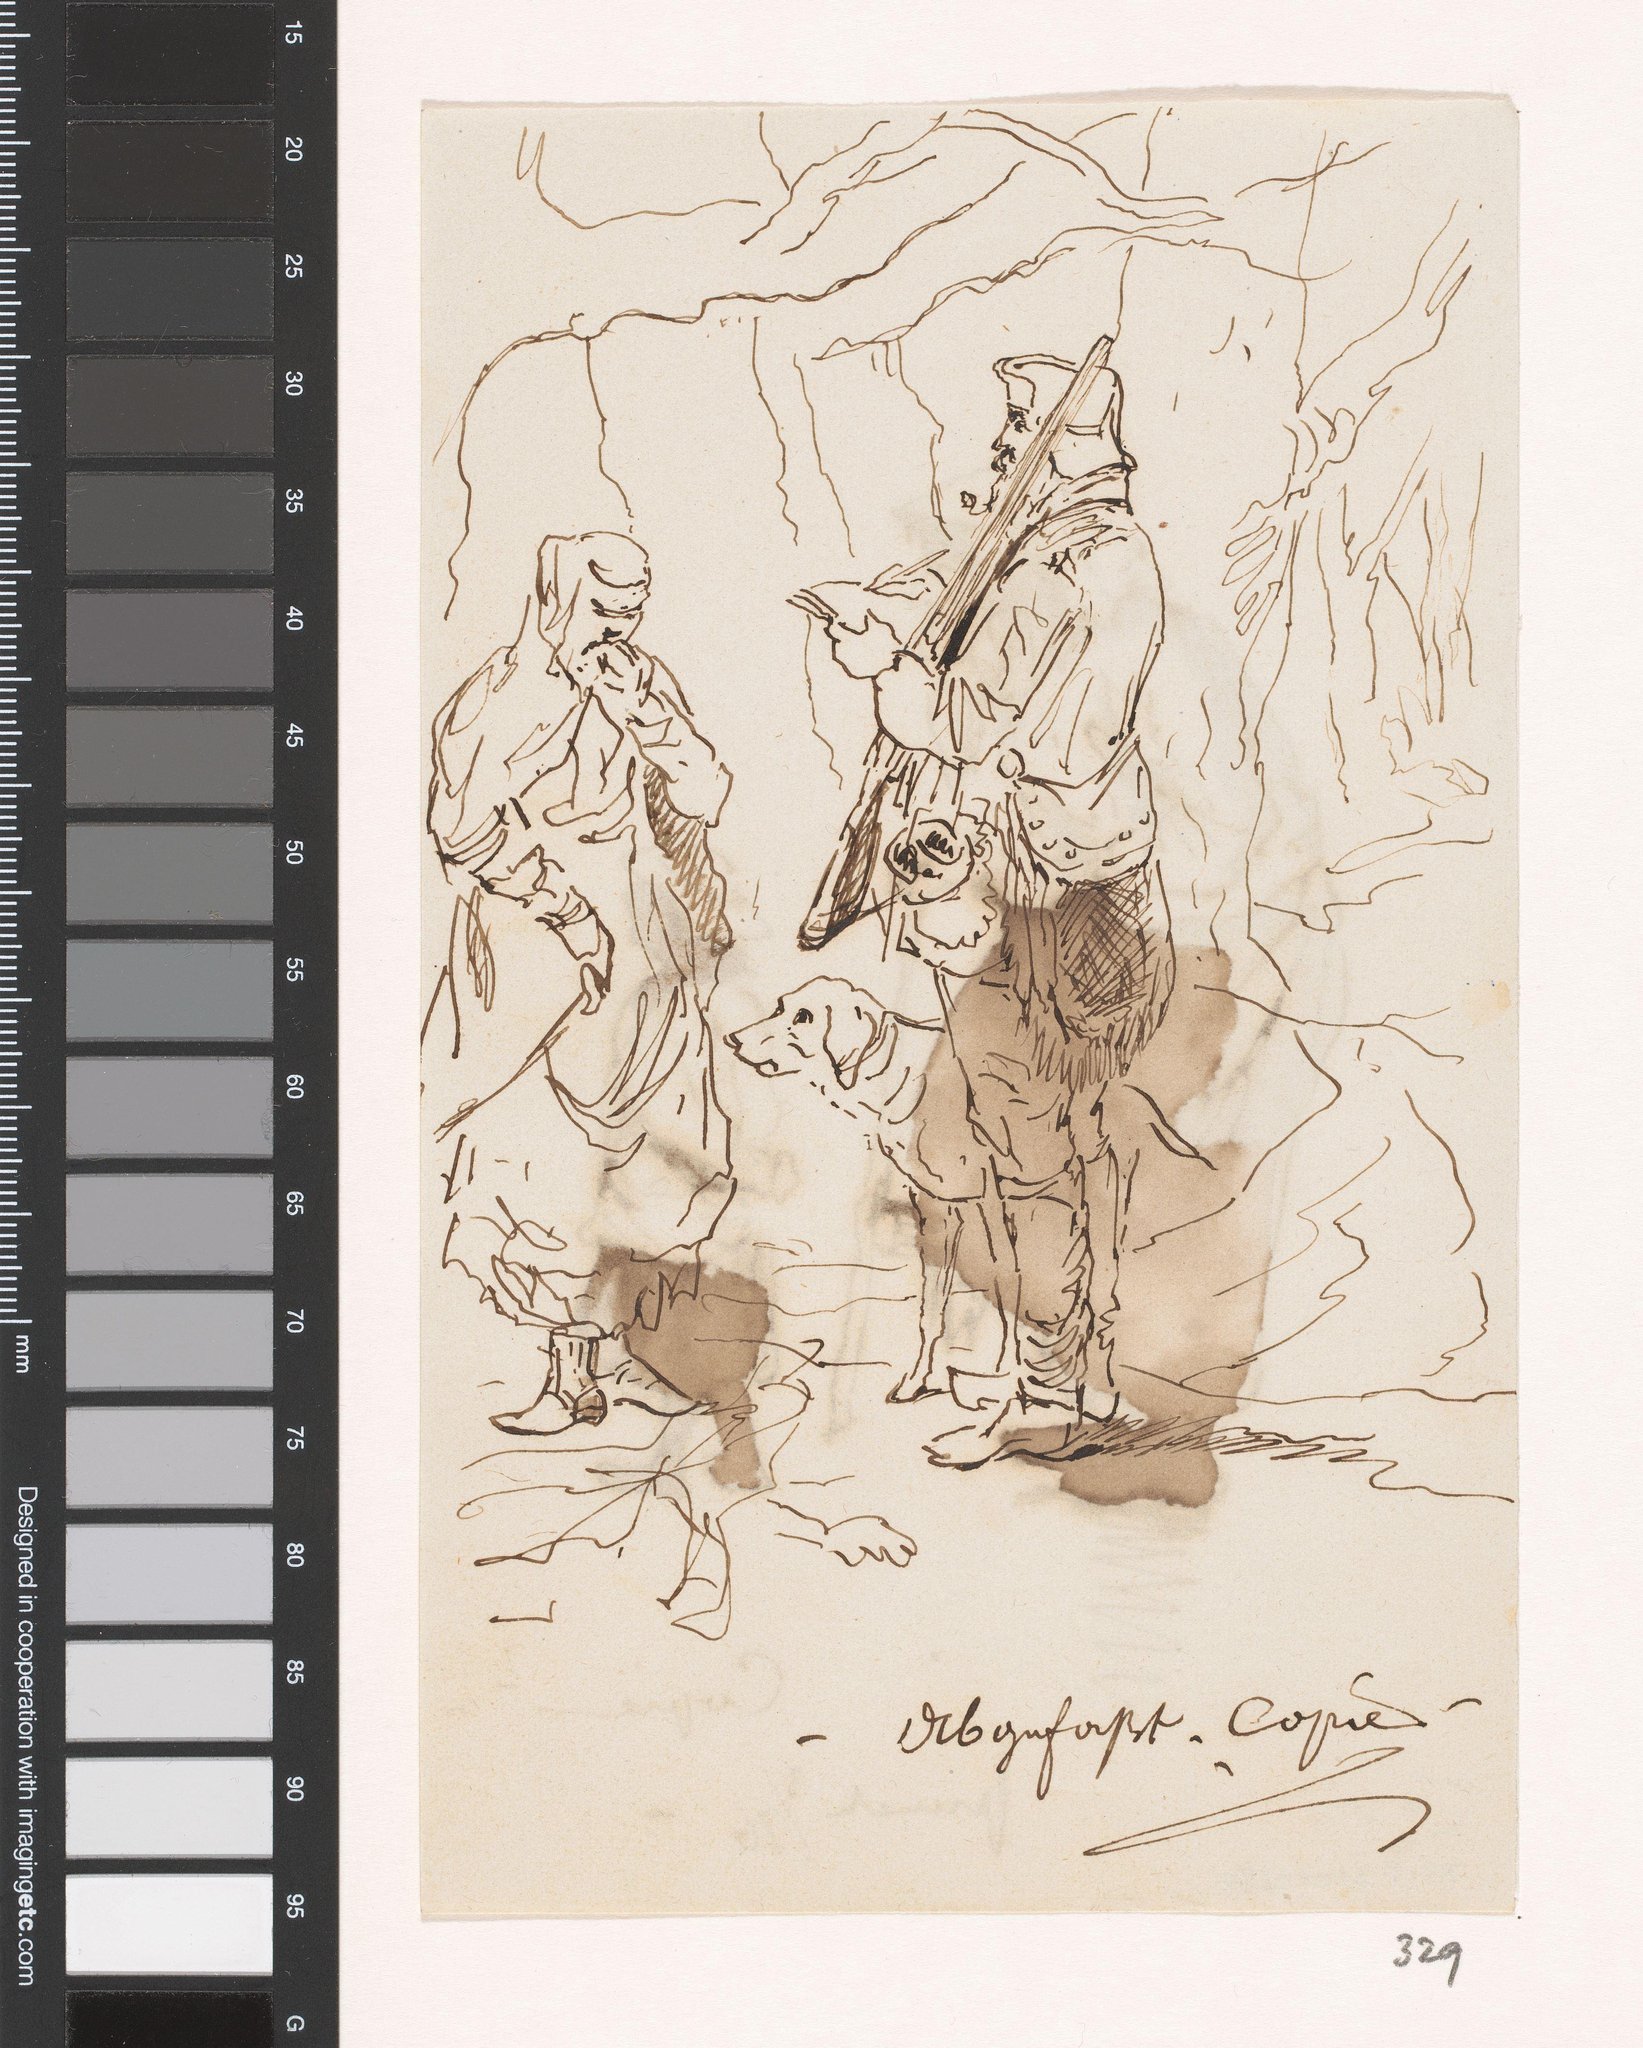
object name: drawing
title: Jagers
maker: johannes tavenraat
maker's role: draughtsman, painter, print maker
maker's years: 1809-1881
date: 1803-1876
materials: ink, paper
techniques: pen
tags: hunters resting during the hunt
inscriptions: date: ‘3/76’, annotation: ‘...foßt - Copie’, collector's mark: Lugt 2228